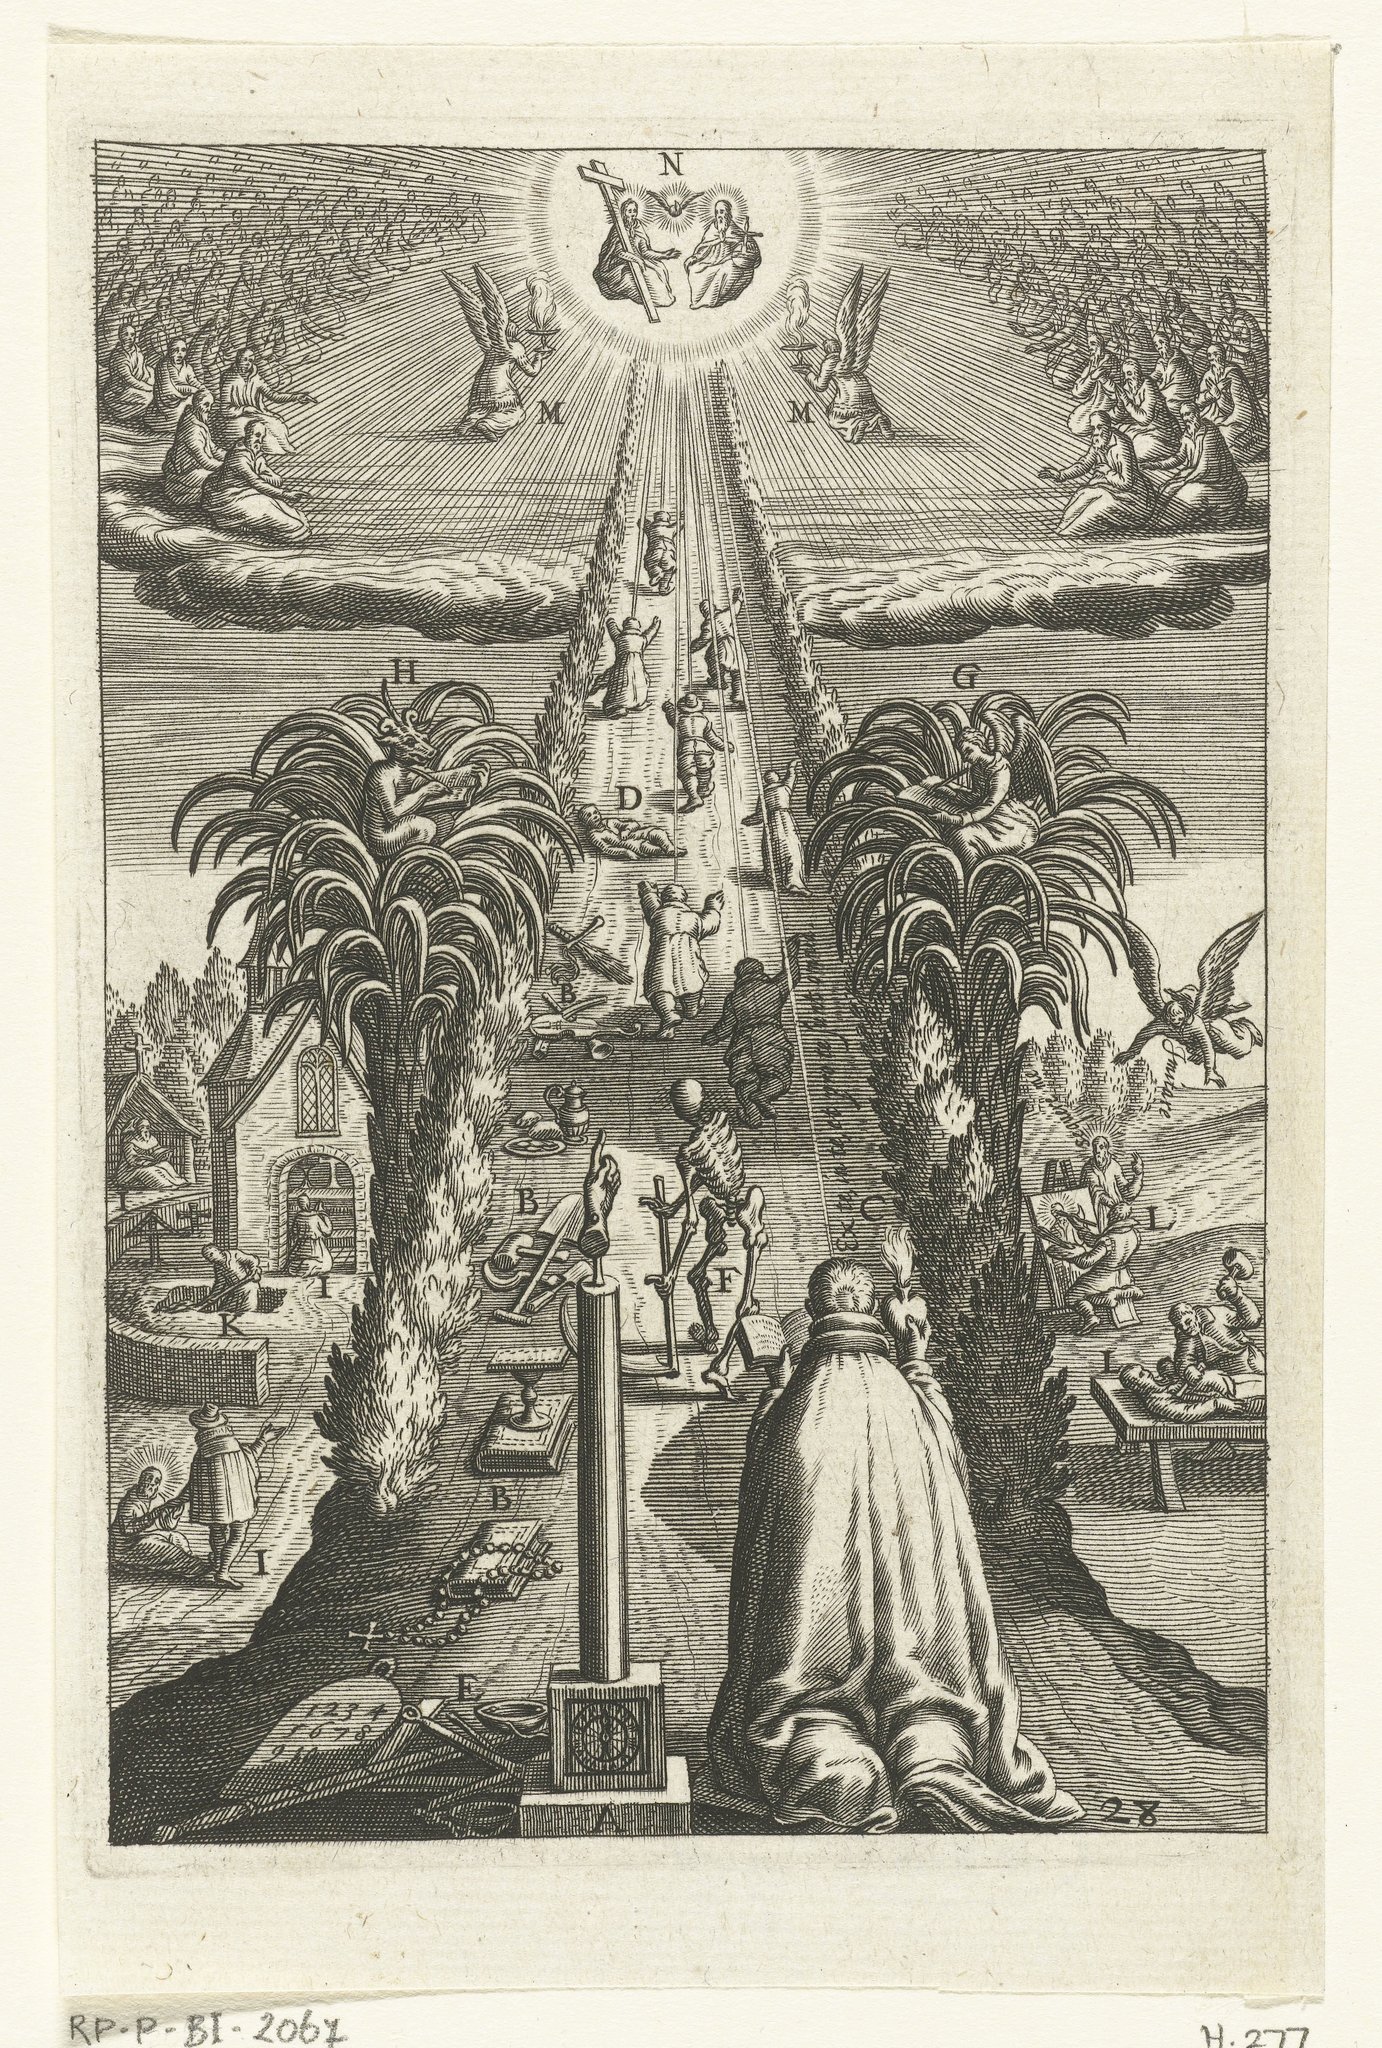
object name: book illustration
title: Den wech des eeuwich levens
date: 1620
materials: paper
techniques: engraving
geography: antwerp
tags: the life of man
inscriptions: collector's mark: Lugt 2228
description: Prent uit: Antoine Sucquet, Den wech des eeuwich levens, beschreven int latijn : met beelden verlicht door Boëtius a Bolsvert, Antwerpen, Hendrick Aertssens, 1620, afb. tegenover p. 632